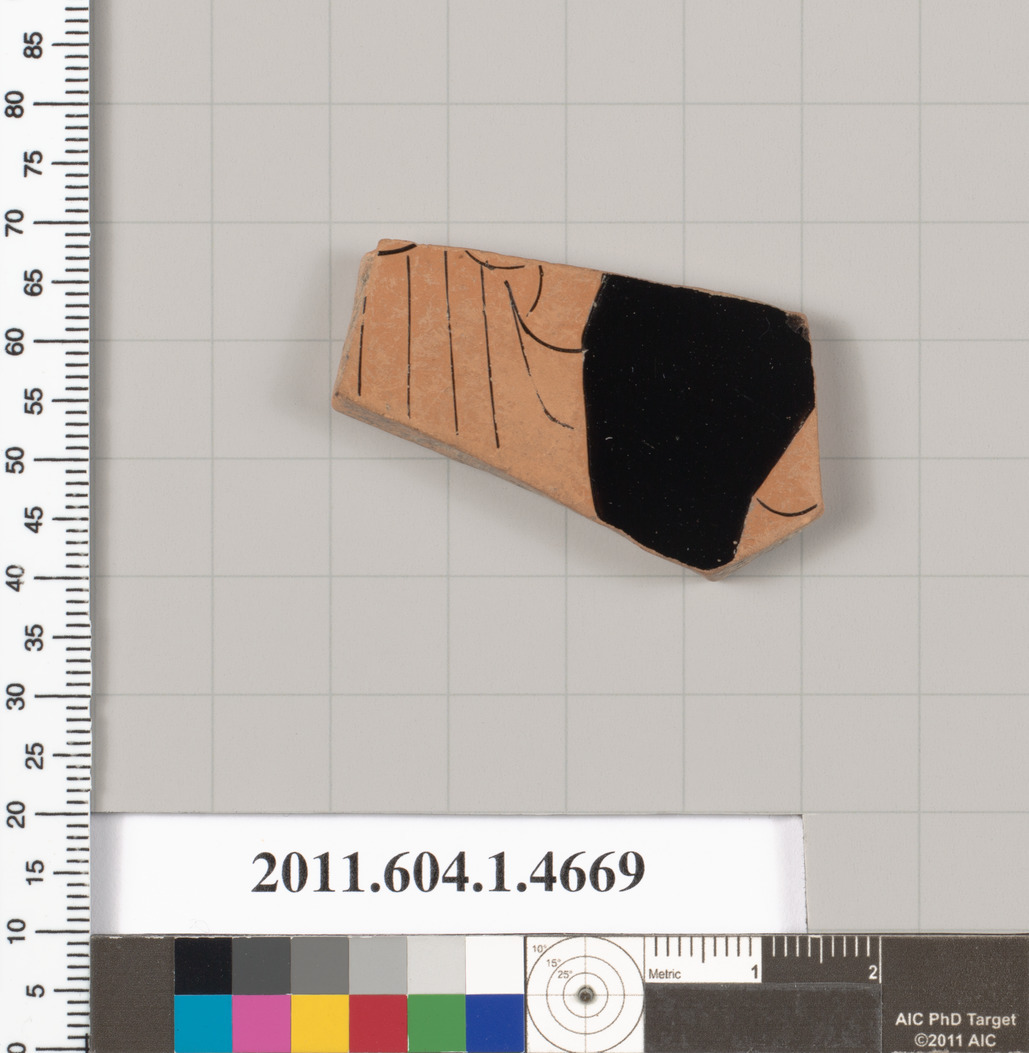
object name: kylix fragment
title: Terracotta fragment of a kylix (drinking cup)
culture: greek, attic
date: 475-451 BCE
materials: terracotta